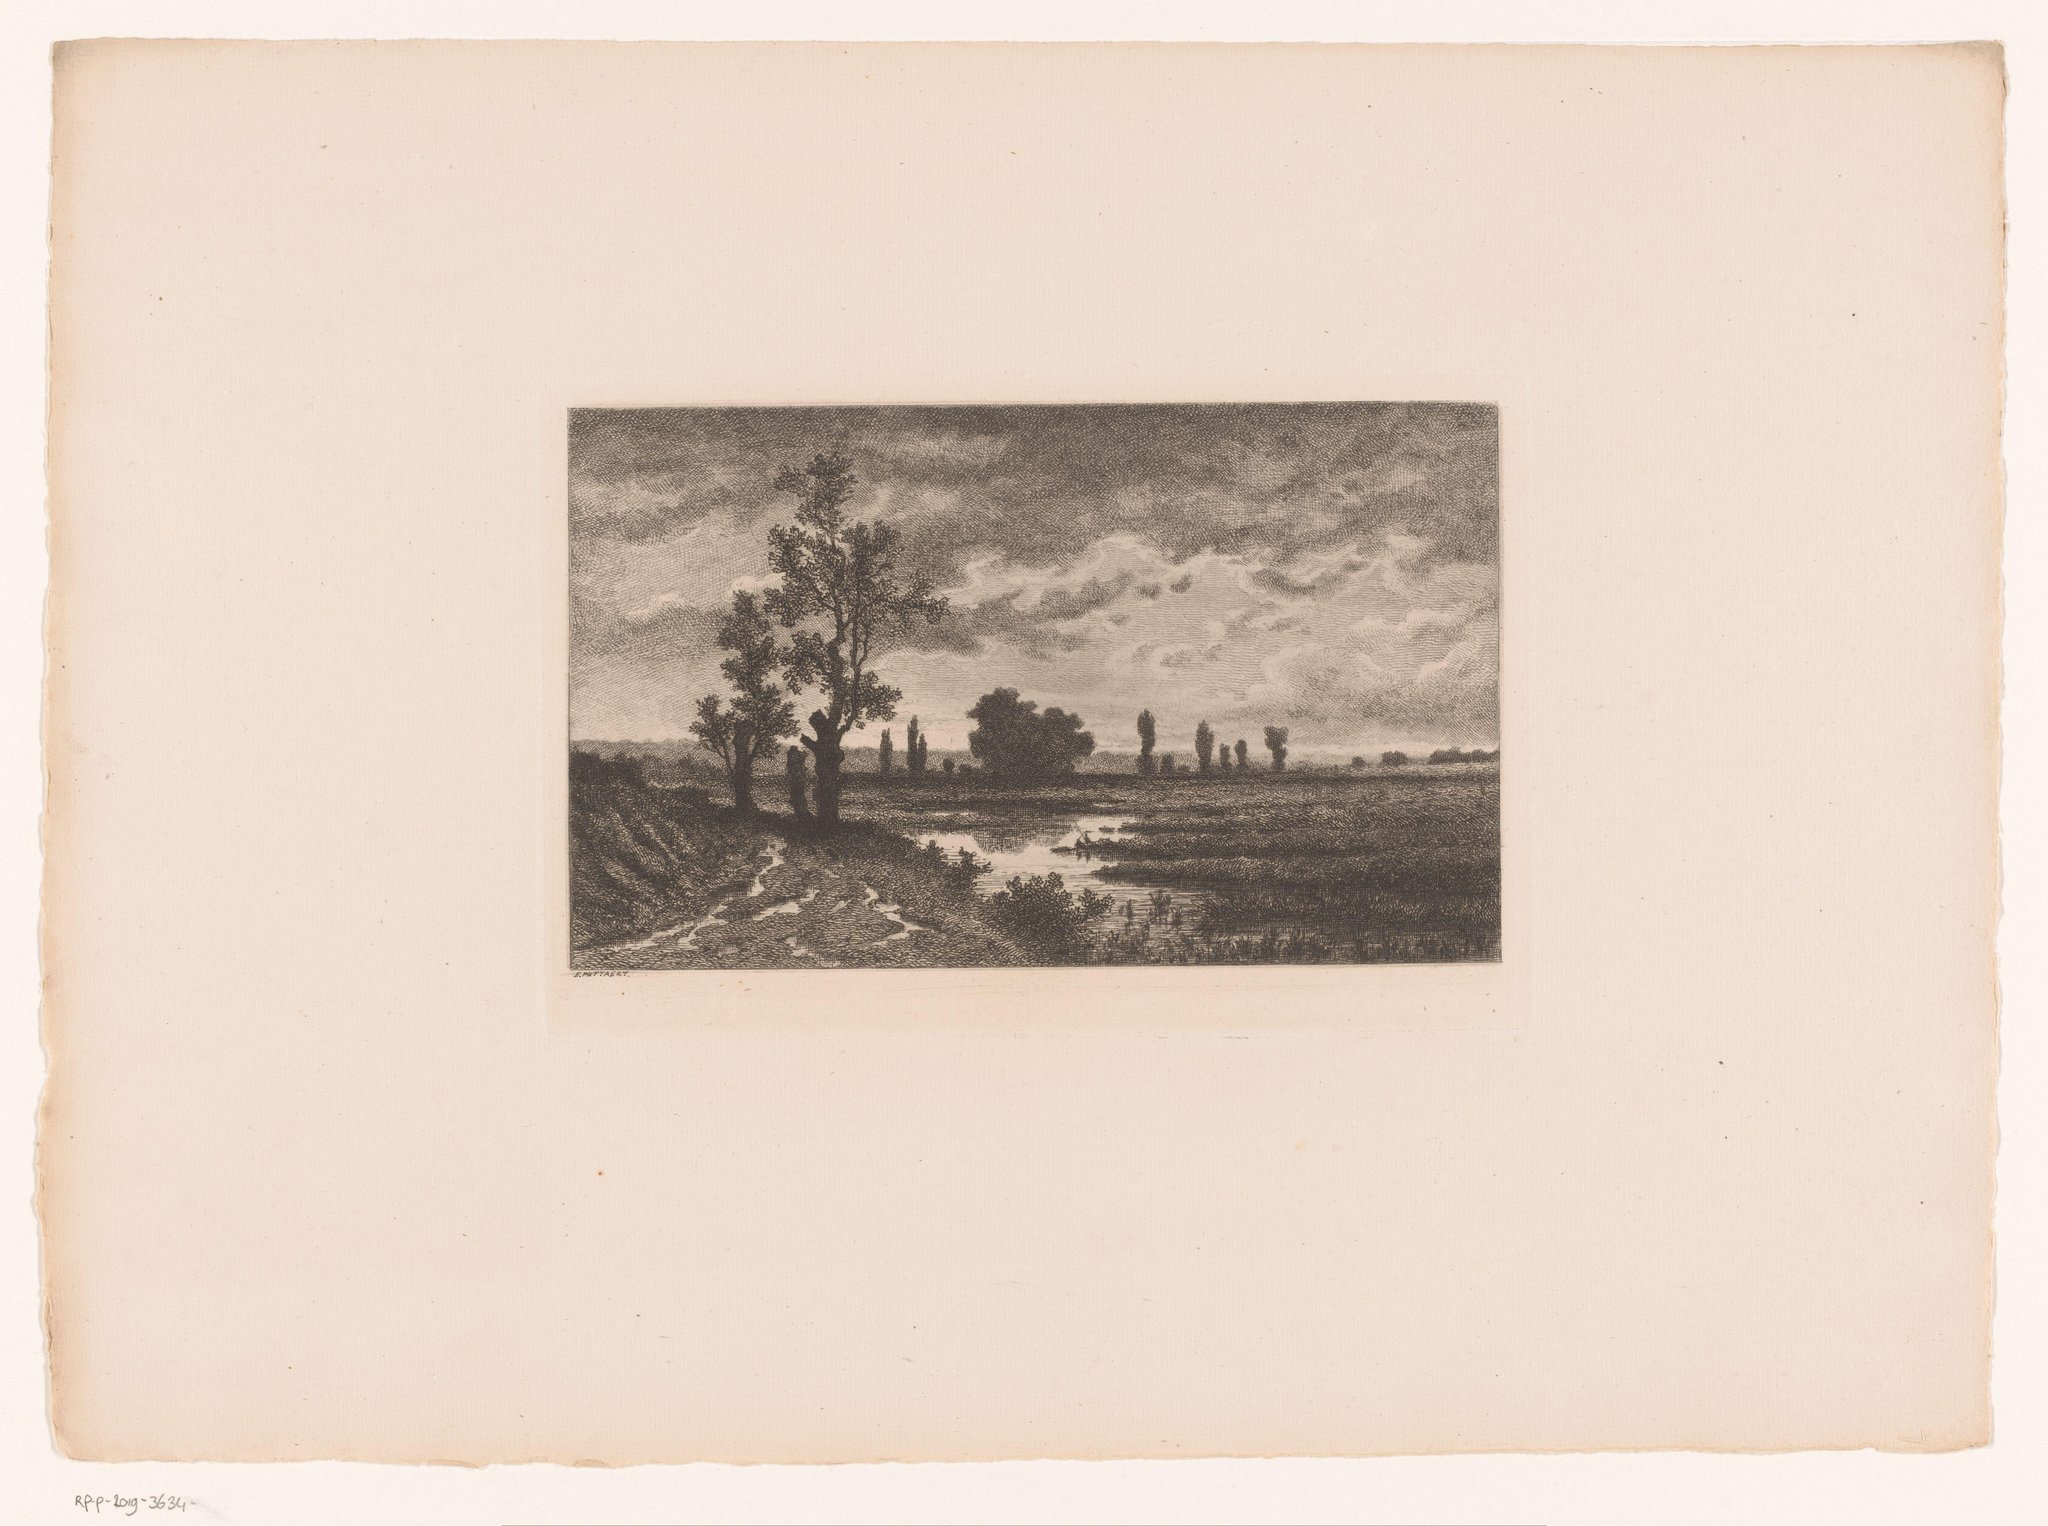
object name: print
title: Gezicht op de Leie nabij Gent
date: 1875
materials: paper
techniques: etching, intaglio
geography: brussels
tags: landscapes with waters, waterscapes, seascapes (in the temperate zone)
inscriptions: collector's mark: Lugt 2228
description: Prent verschenen onder de titel 'd'apres orage' in: Rops, Félicien (red.). Cahier d'études: eaux-fortes originales et inédites. Brussel: Felix Callewaert père, 1875.